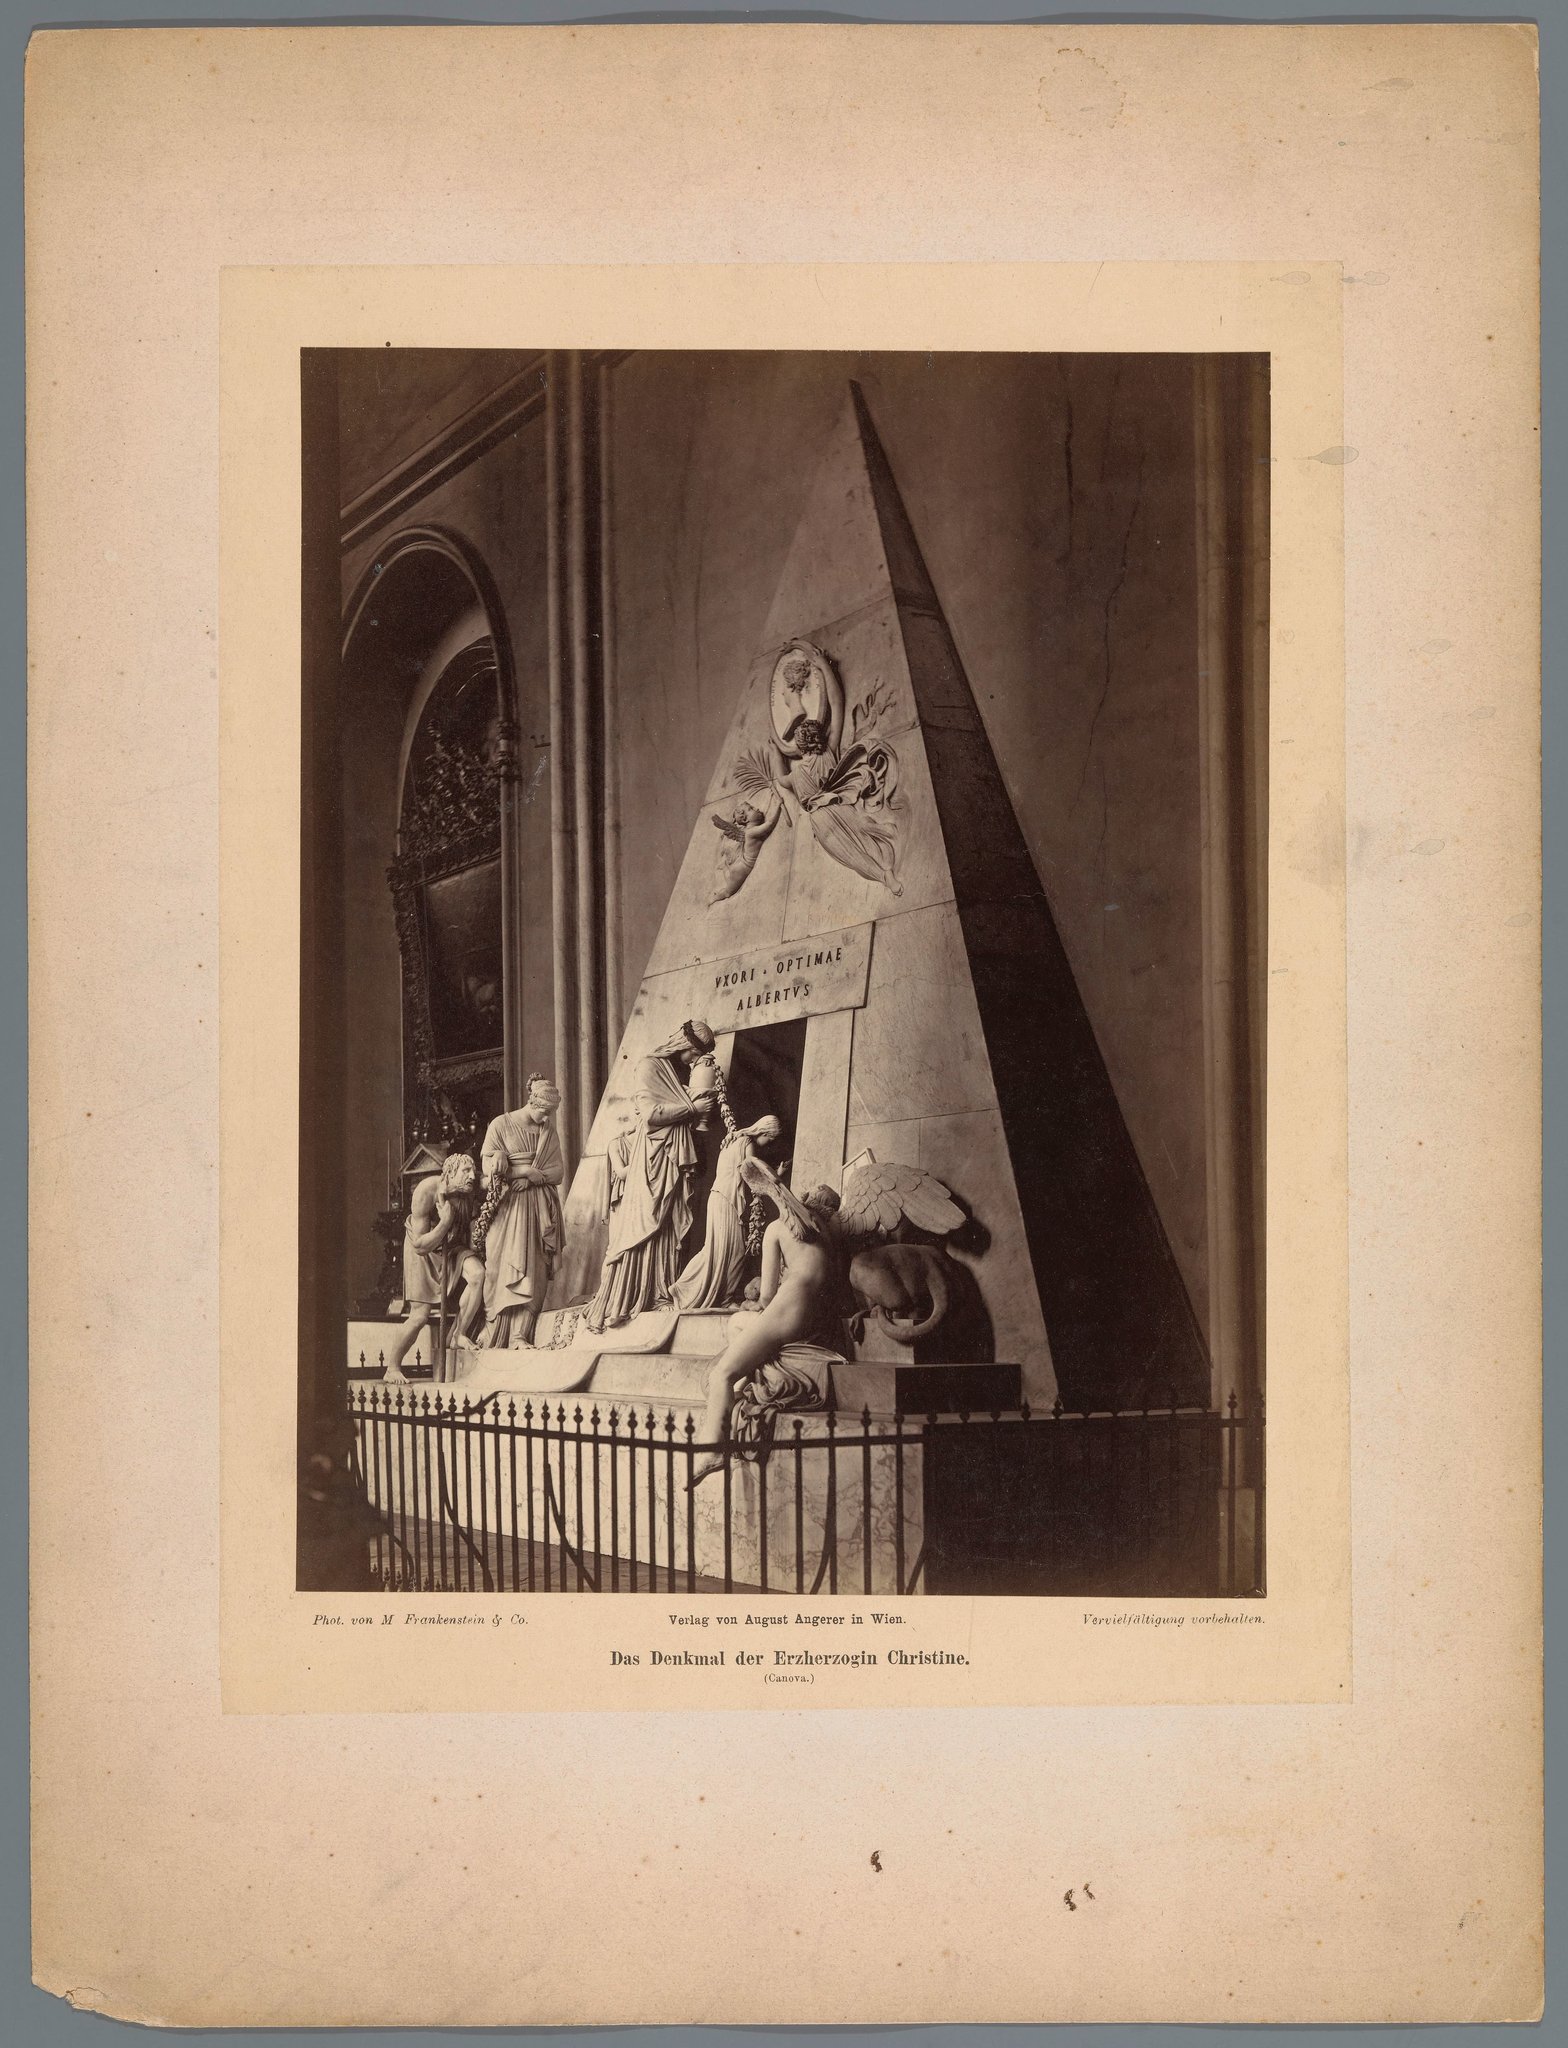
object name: photograph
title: Das Denkmal der Erzherzogin Christine. (Canova.)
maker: august angerer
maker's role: publisher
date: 1875-1900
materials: cardboard, photographic support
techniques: albumen print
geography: vienna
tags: triangular pyramid, interior of church, monument, statue, sculpture, vienna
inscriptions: collector's mark: Lugt 3937